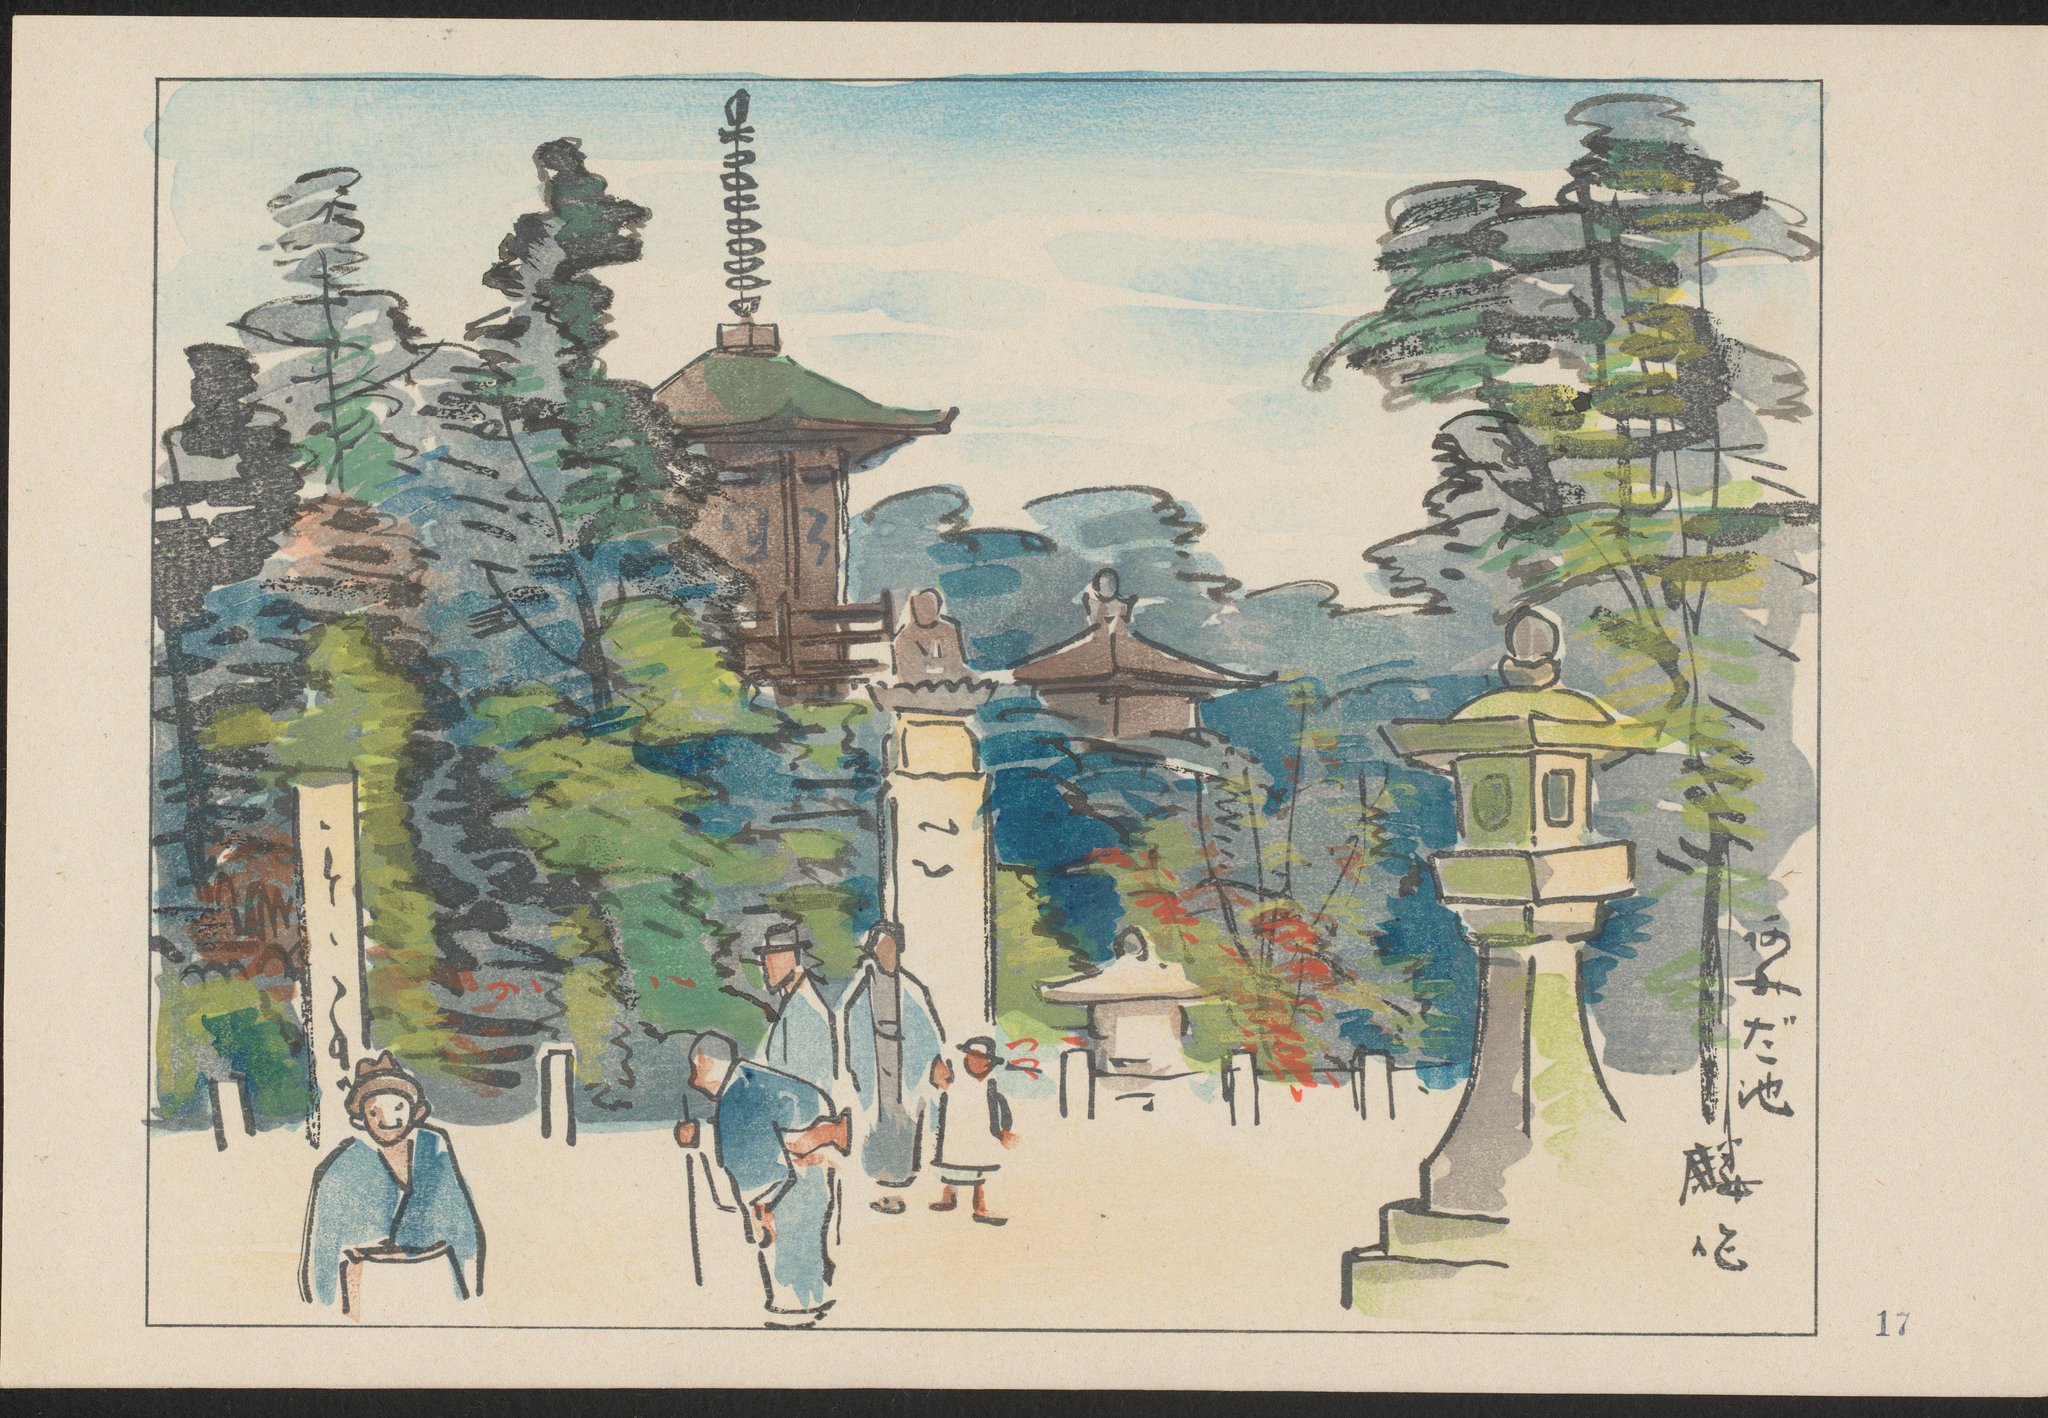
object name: print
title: Amida pond, the Buddha statue presented by the Korean King to the Japanese Emperor was once thrown in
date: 1947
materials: paper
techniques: woodcut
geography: japan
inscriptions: date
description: De ingang omringt door bomen van de Wako-ji tempel in Osaka, waar de Amida vijver is gelegen.